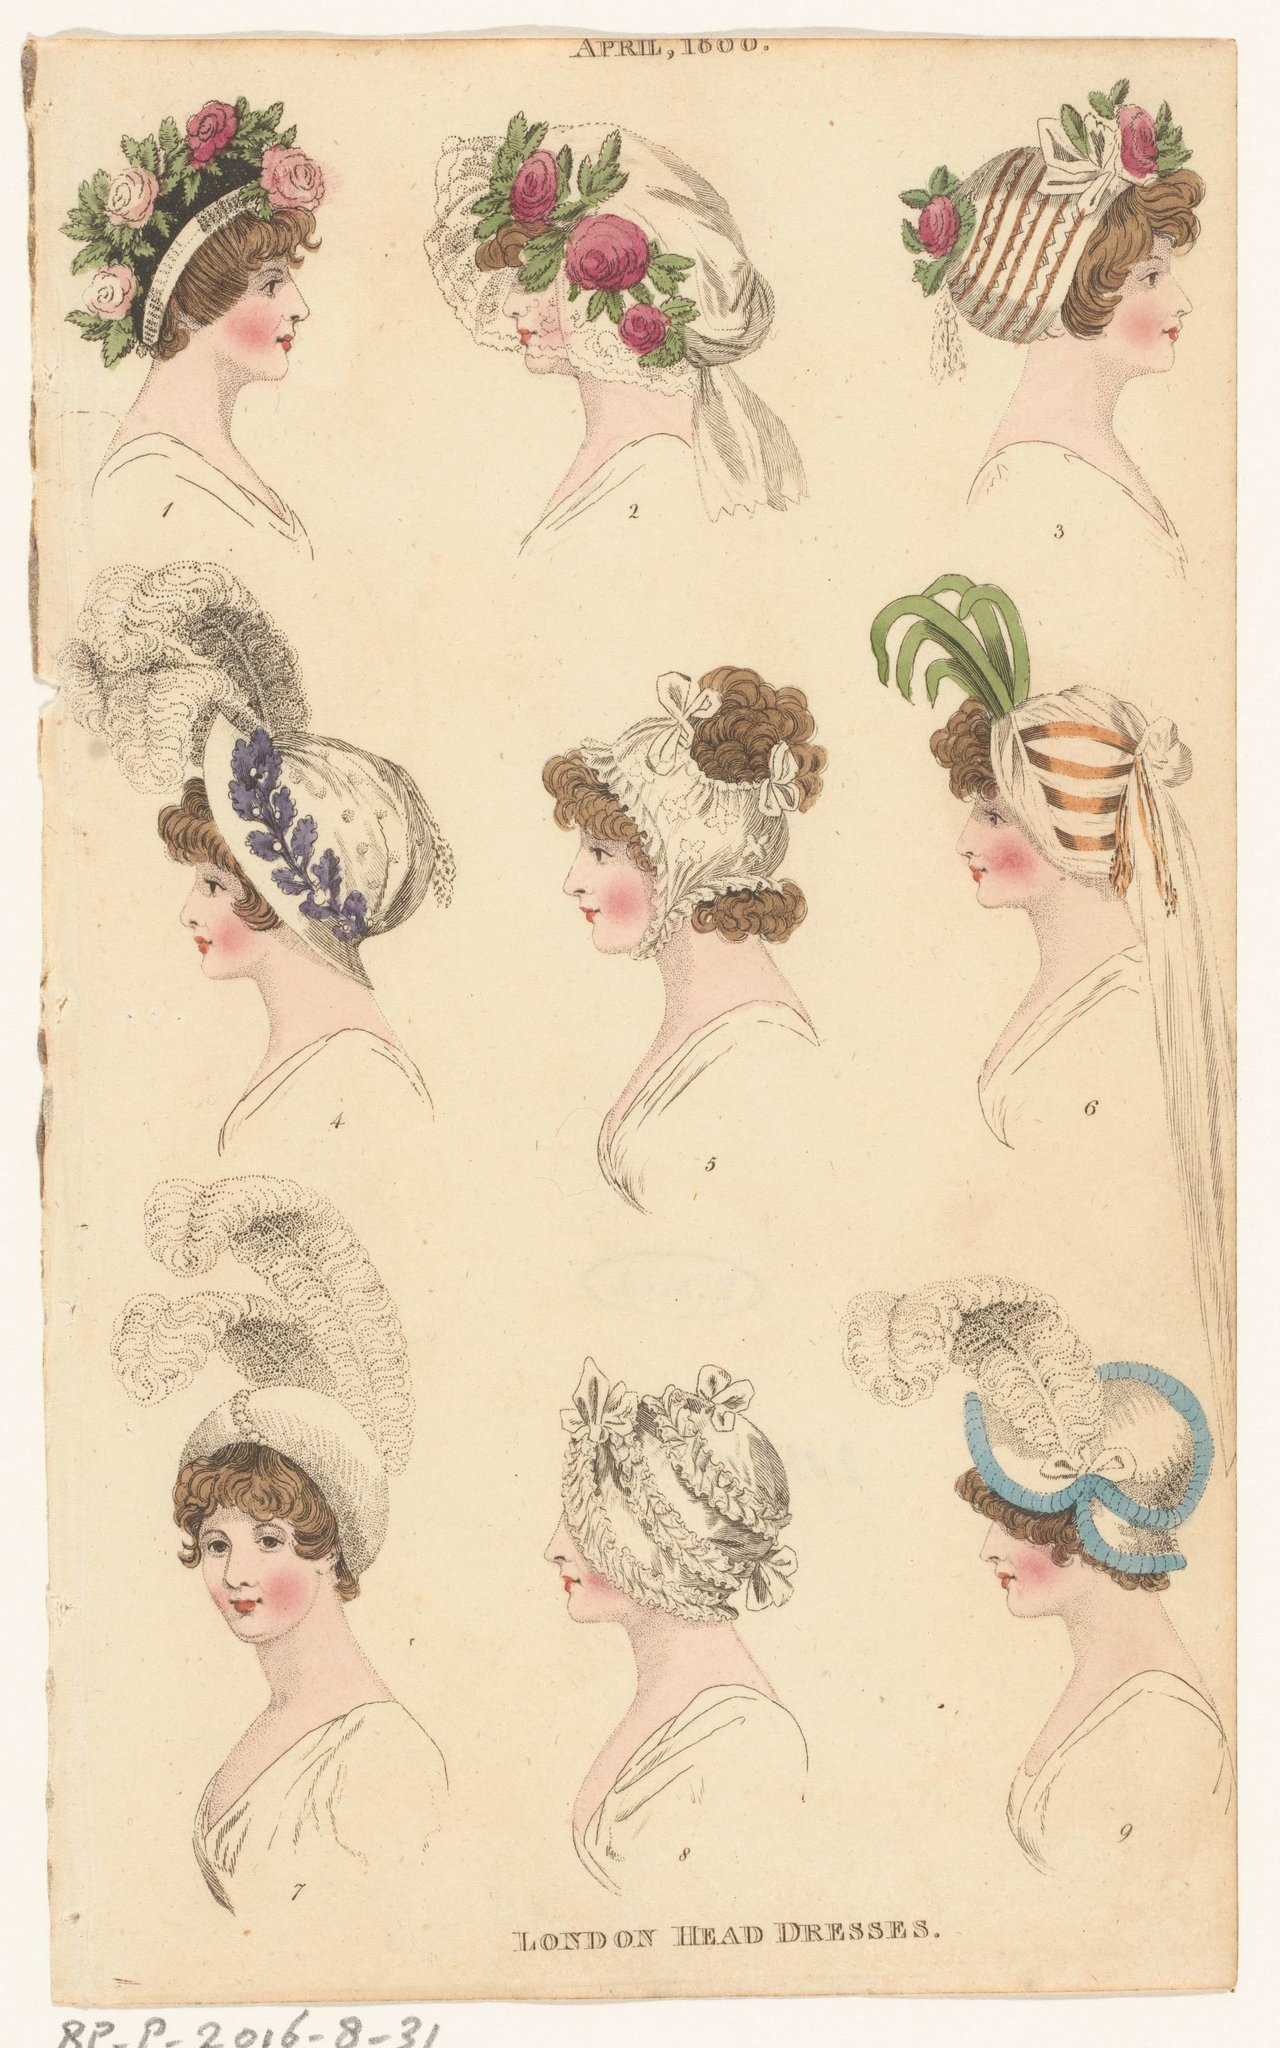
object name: fashion print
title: Magazine of Female Fashions of London and Paris, April 1800, London Head Dresses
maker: richard phillips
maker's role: bookseller, publisher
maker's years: 1767-1840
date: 1800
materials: paper, ink, watercolor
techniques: engraving, etching, hand coloring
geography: london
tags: head-gear: cap (+ women's clothes), fashion plates, head-gear: hat (+ women's clothes)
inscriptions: caption: ‘London Head Dresses’, date: ‘April, 1800’, collector's mark: Lugt 2228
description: Negen verschillende hoeden en mutsen voor vrouwen.